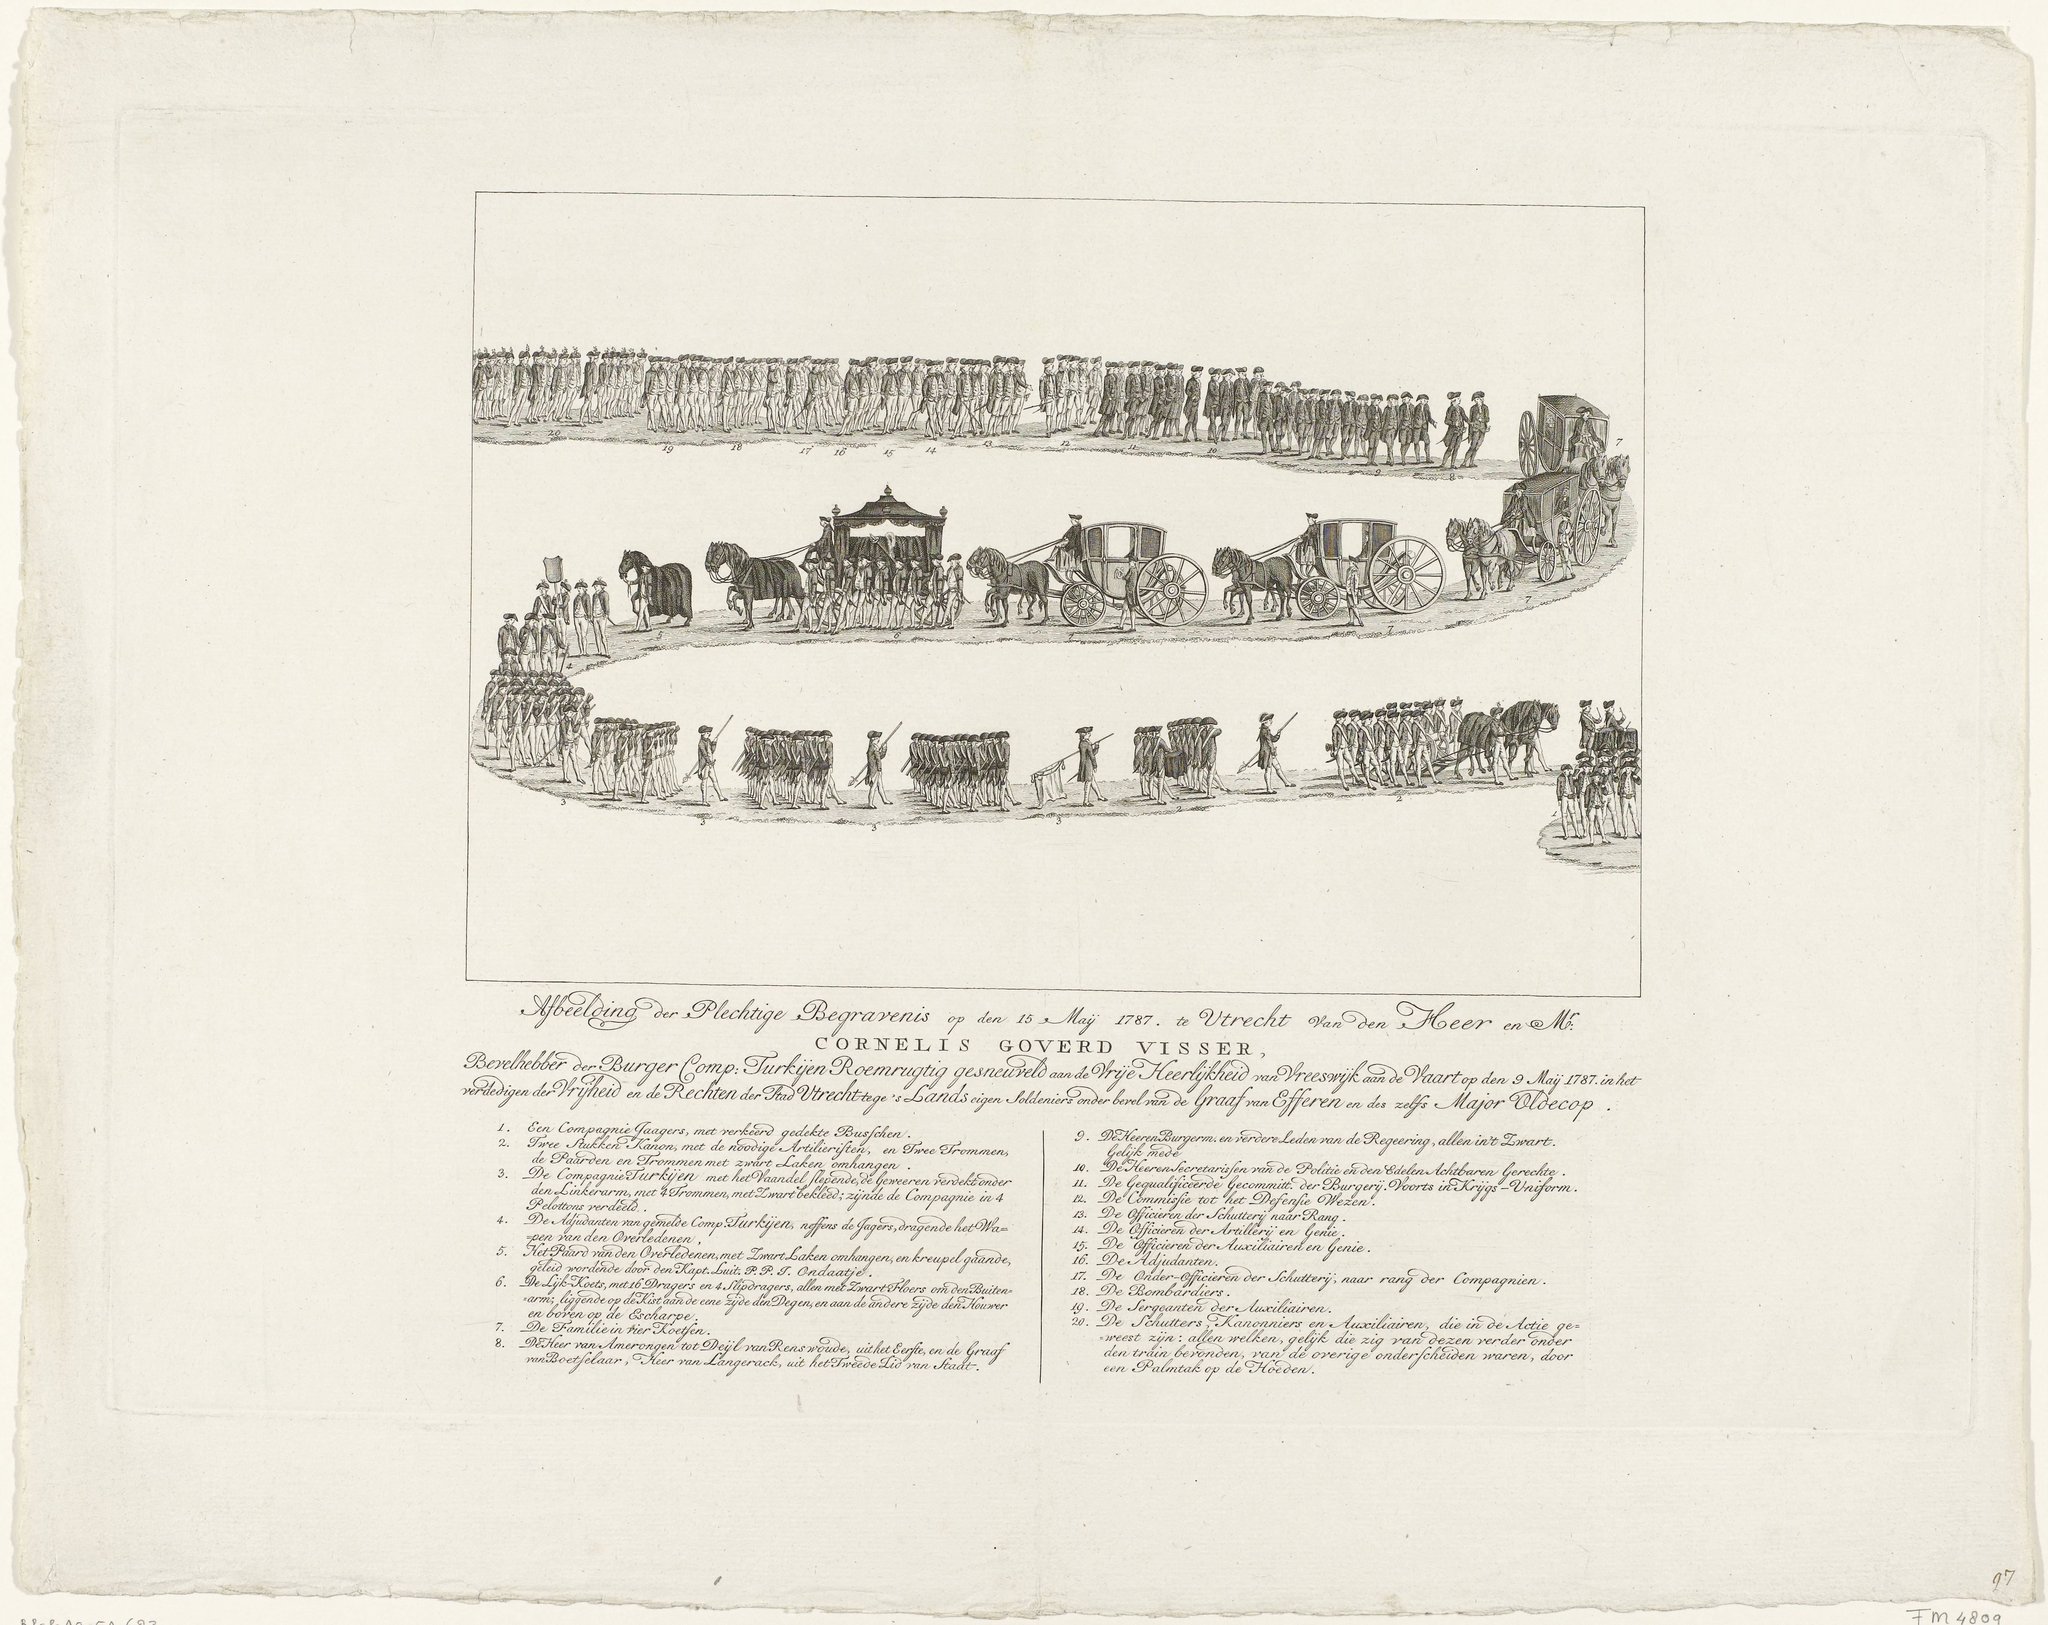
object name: print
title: Begrafenis van Cornelis Govert Visscher, 1787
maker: Anonymous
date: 1787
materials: paper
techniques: etching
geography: northern netherlands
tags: cortege, funeral procession, utrecht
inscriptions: collector's mark: Lugt 2228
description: Begrafenis van Cornelis Govert Visscher, bevelhebber van de Utrechtse burgercompagnie Turkije, gesneuveld in het gevecht bij Vreeswijk op 9 mei, te Utrecht op 15 mei 1787. Begrafenisstoet in drie rijen. Op het blad onder de plaat de legenda 1-20 van de deelnemers in de stoet.